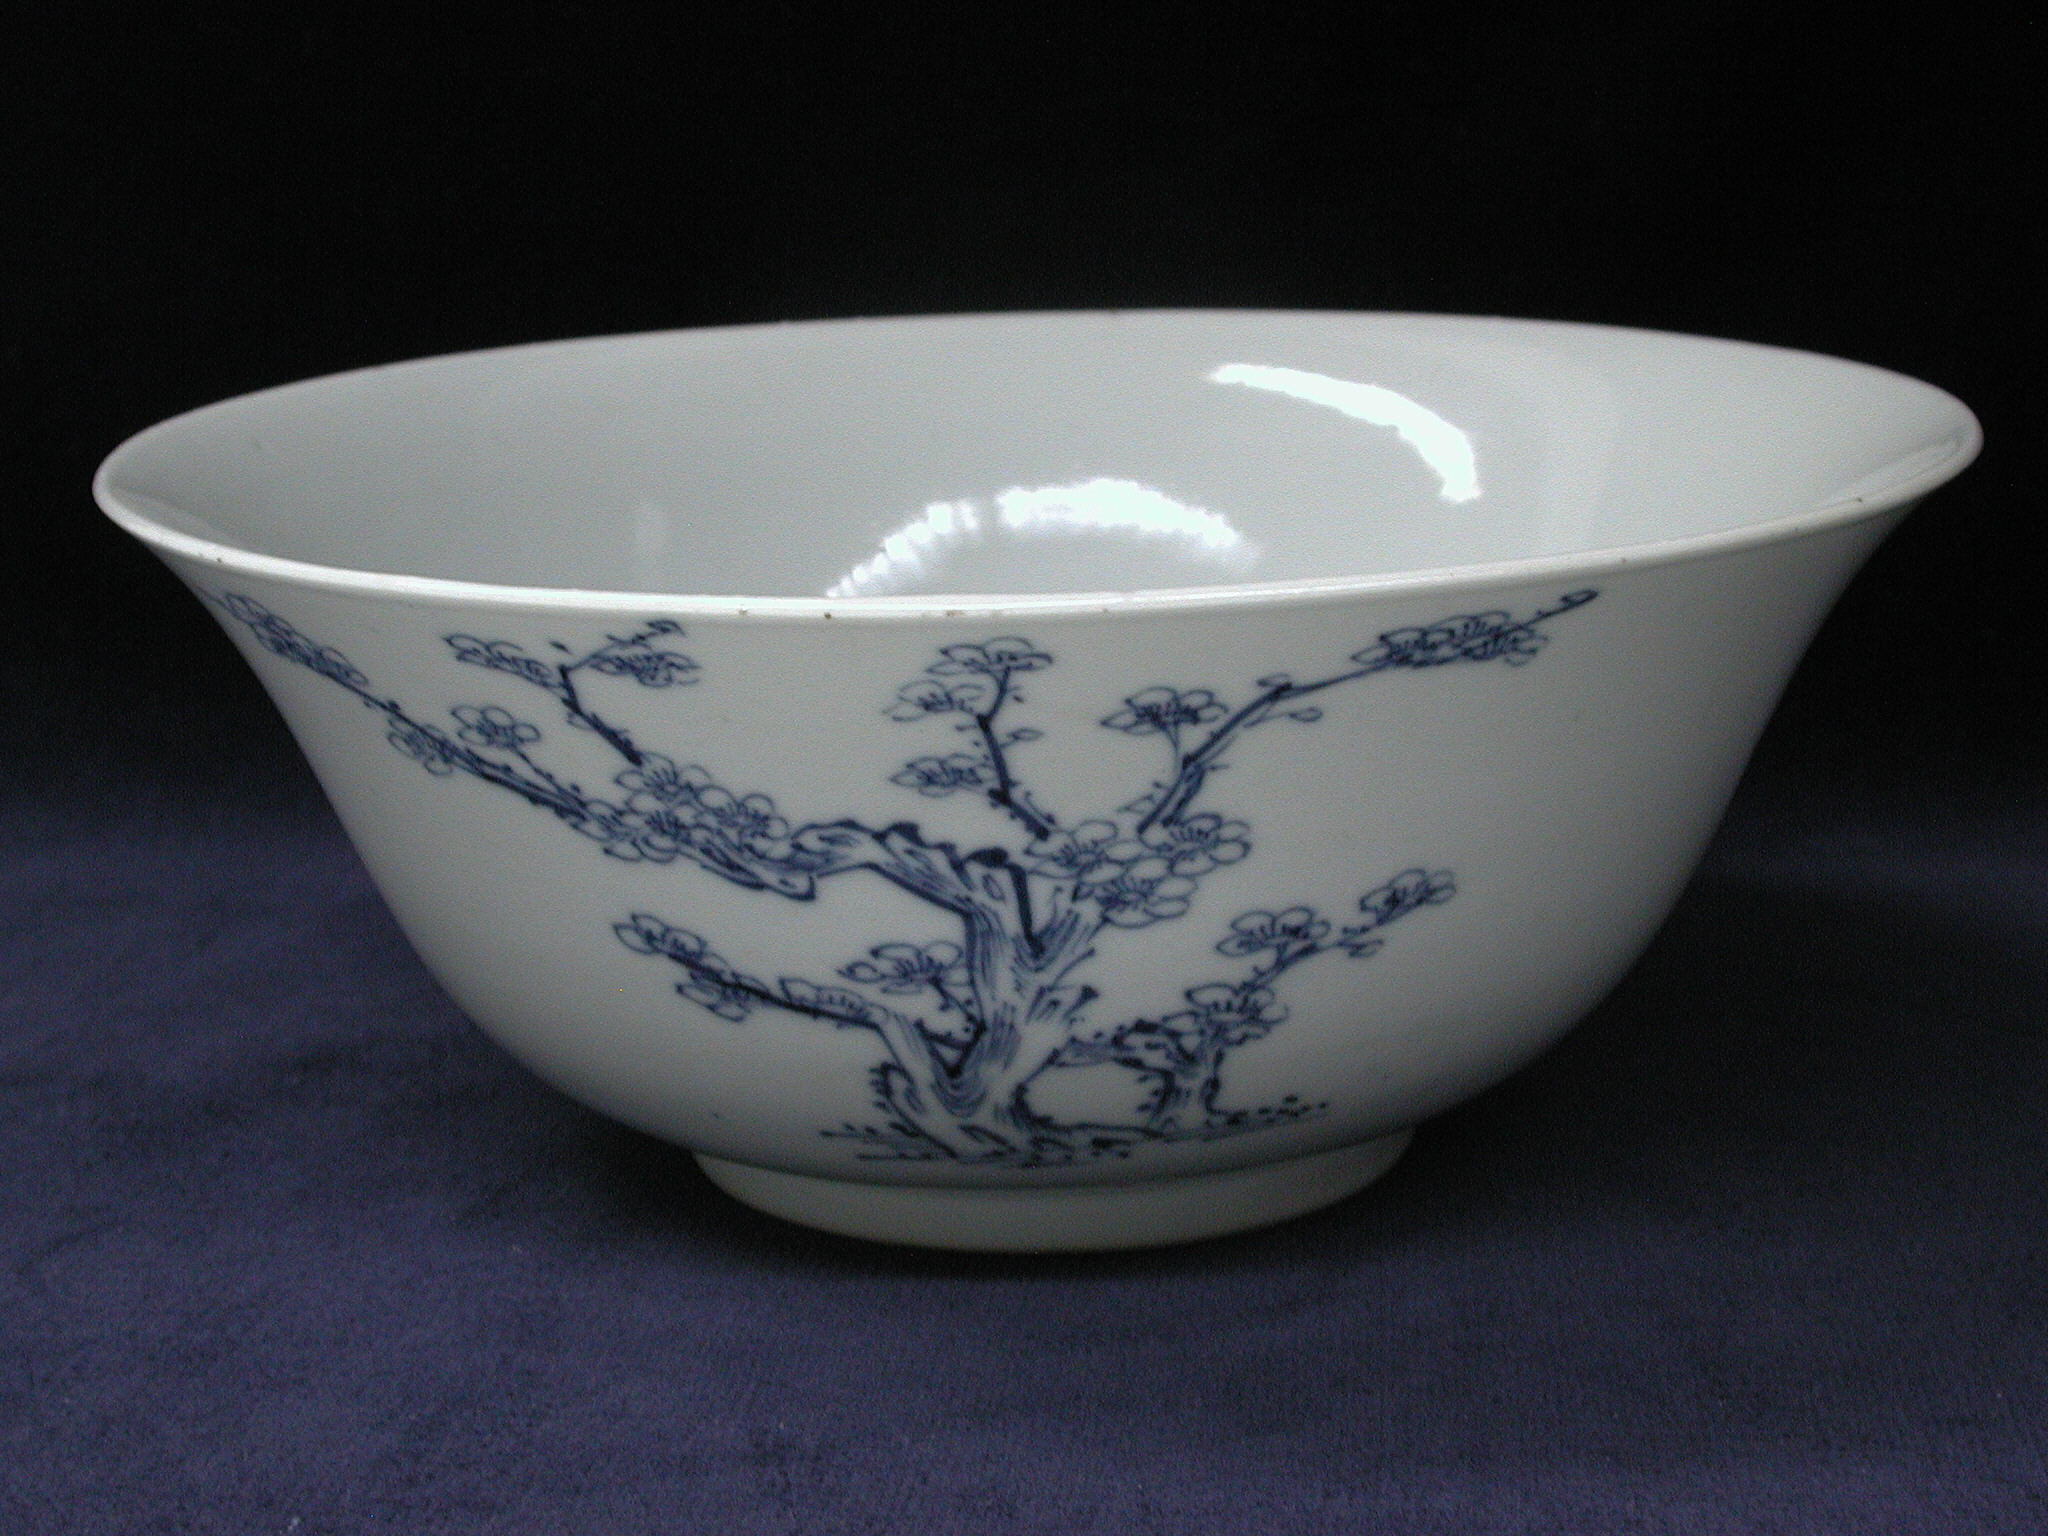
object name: bowl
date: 1701-1800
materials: hard paste porcelain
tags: flowers,trees